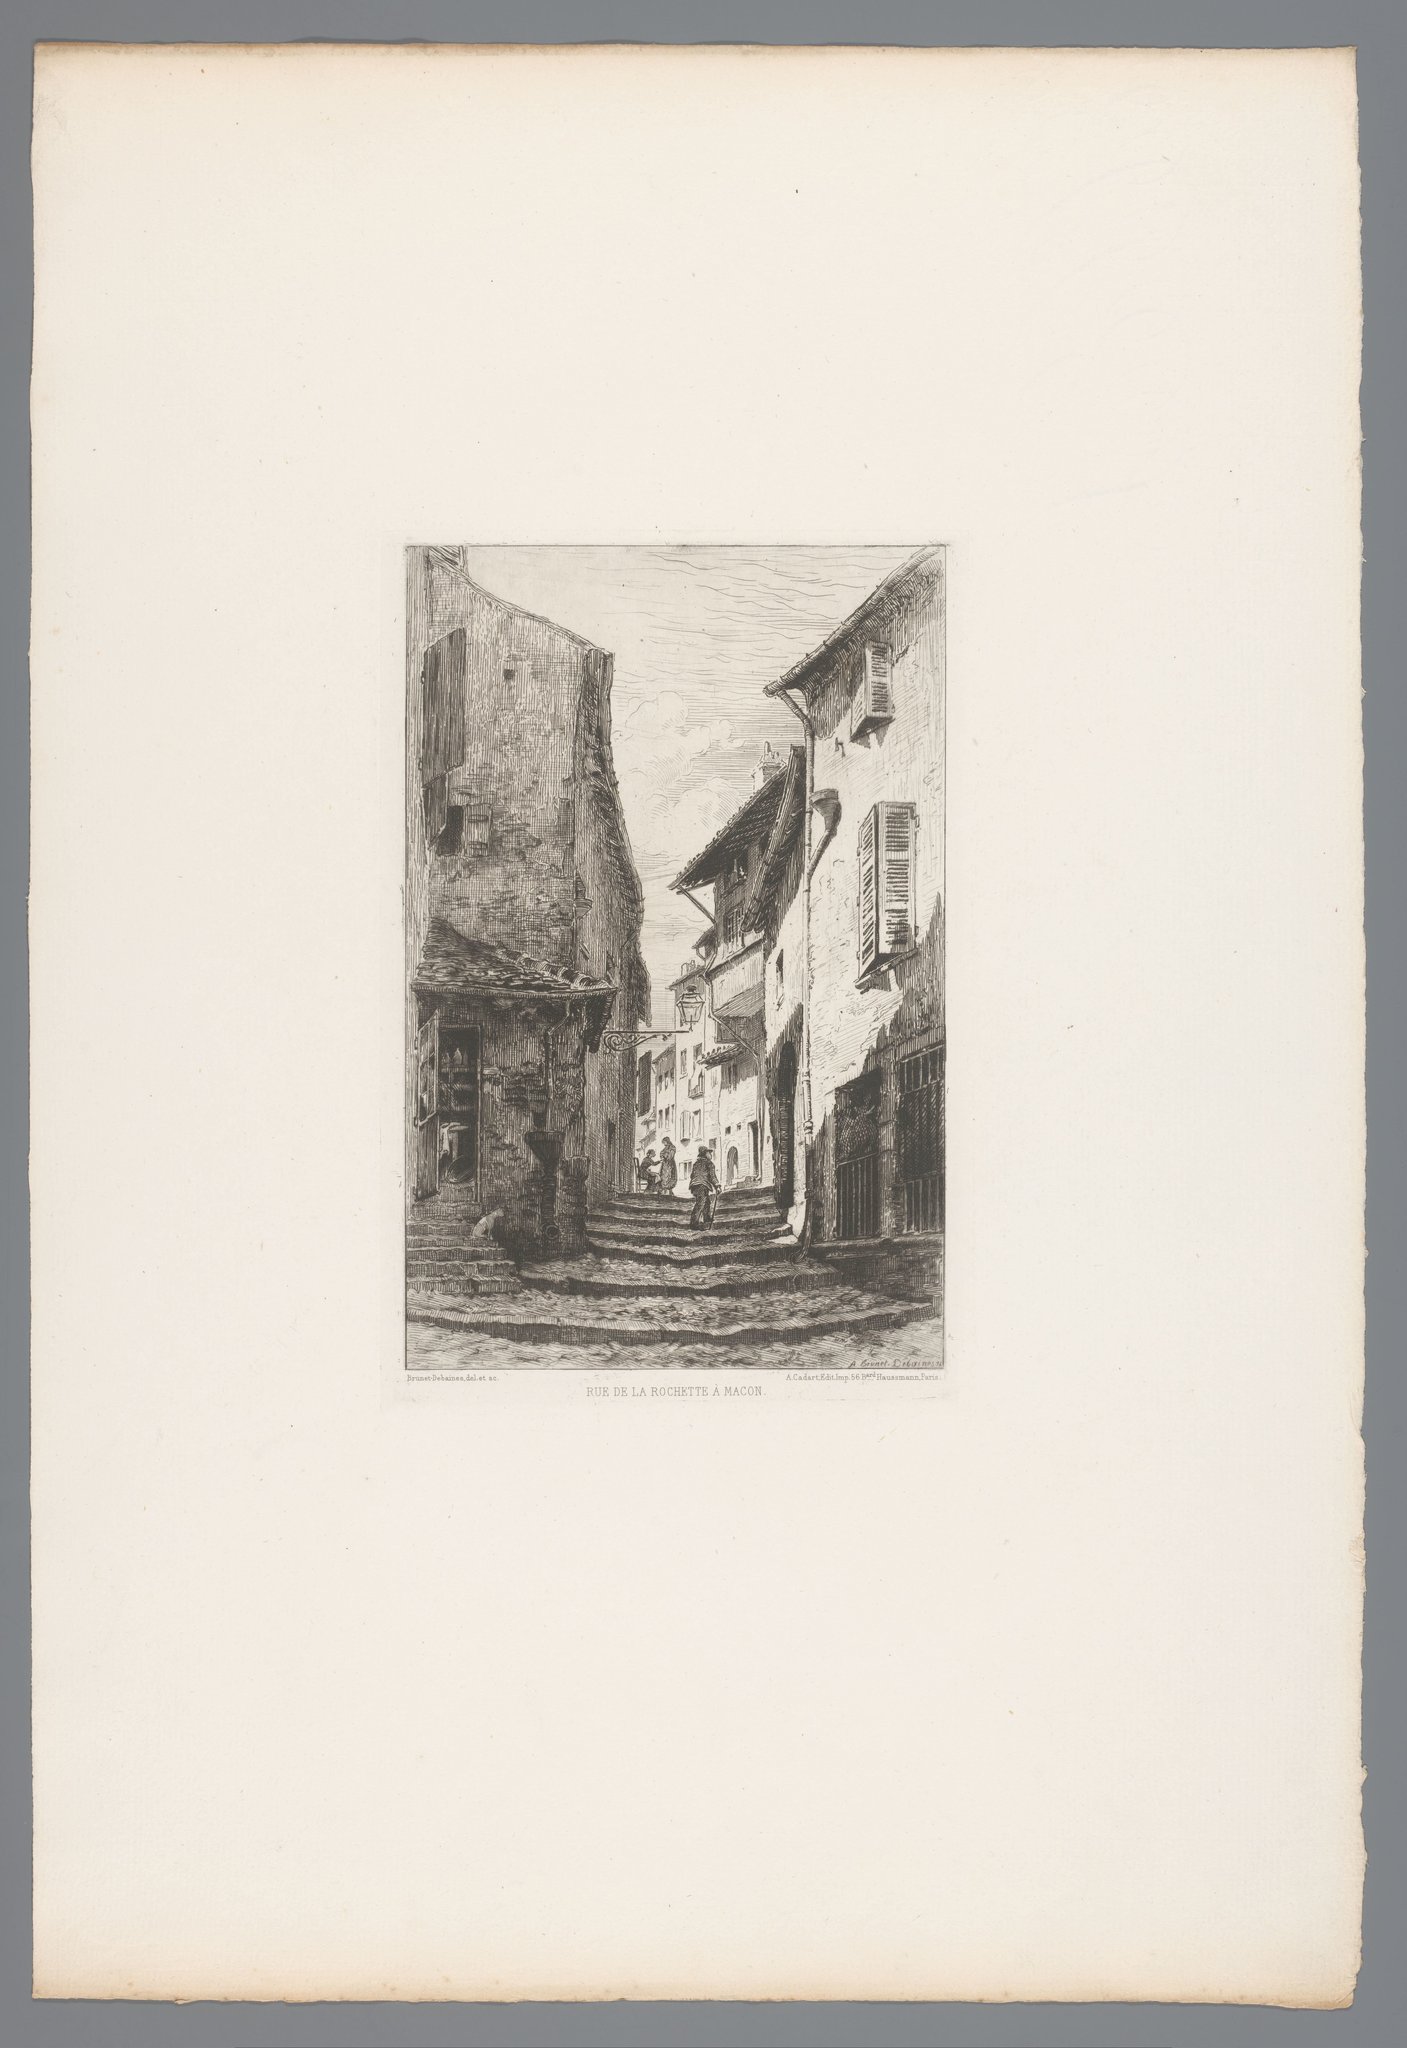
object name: print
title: Gezicht op een straat in Mâcon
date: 1875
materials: paper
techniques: drypoint, etching, intaglio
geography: paris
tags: street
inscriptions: collector's mark: ‘AFE v S’, collector's mark: Lugt 2228, collector's mark: Lugt 2760